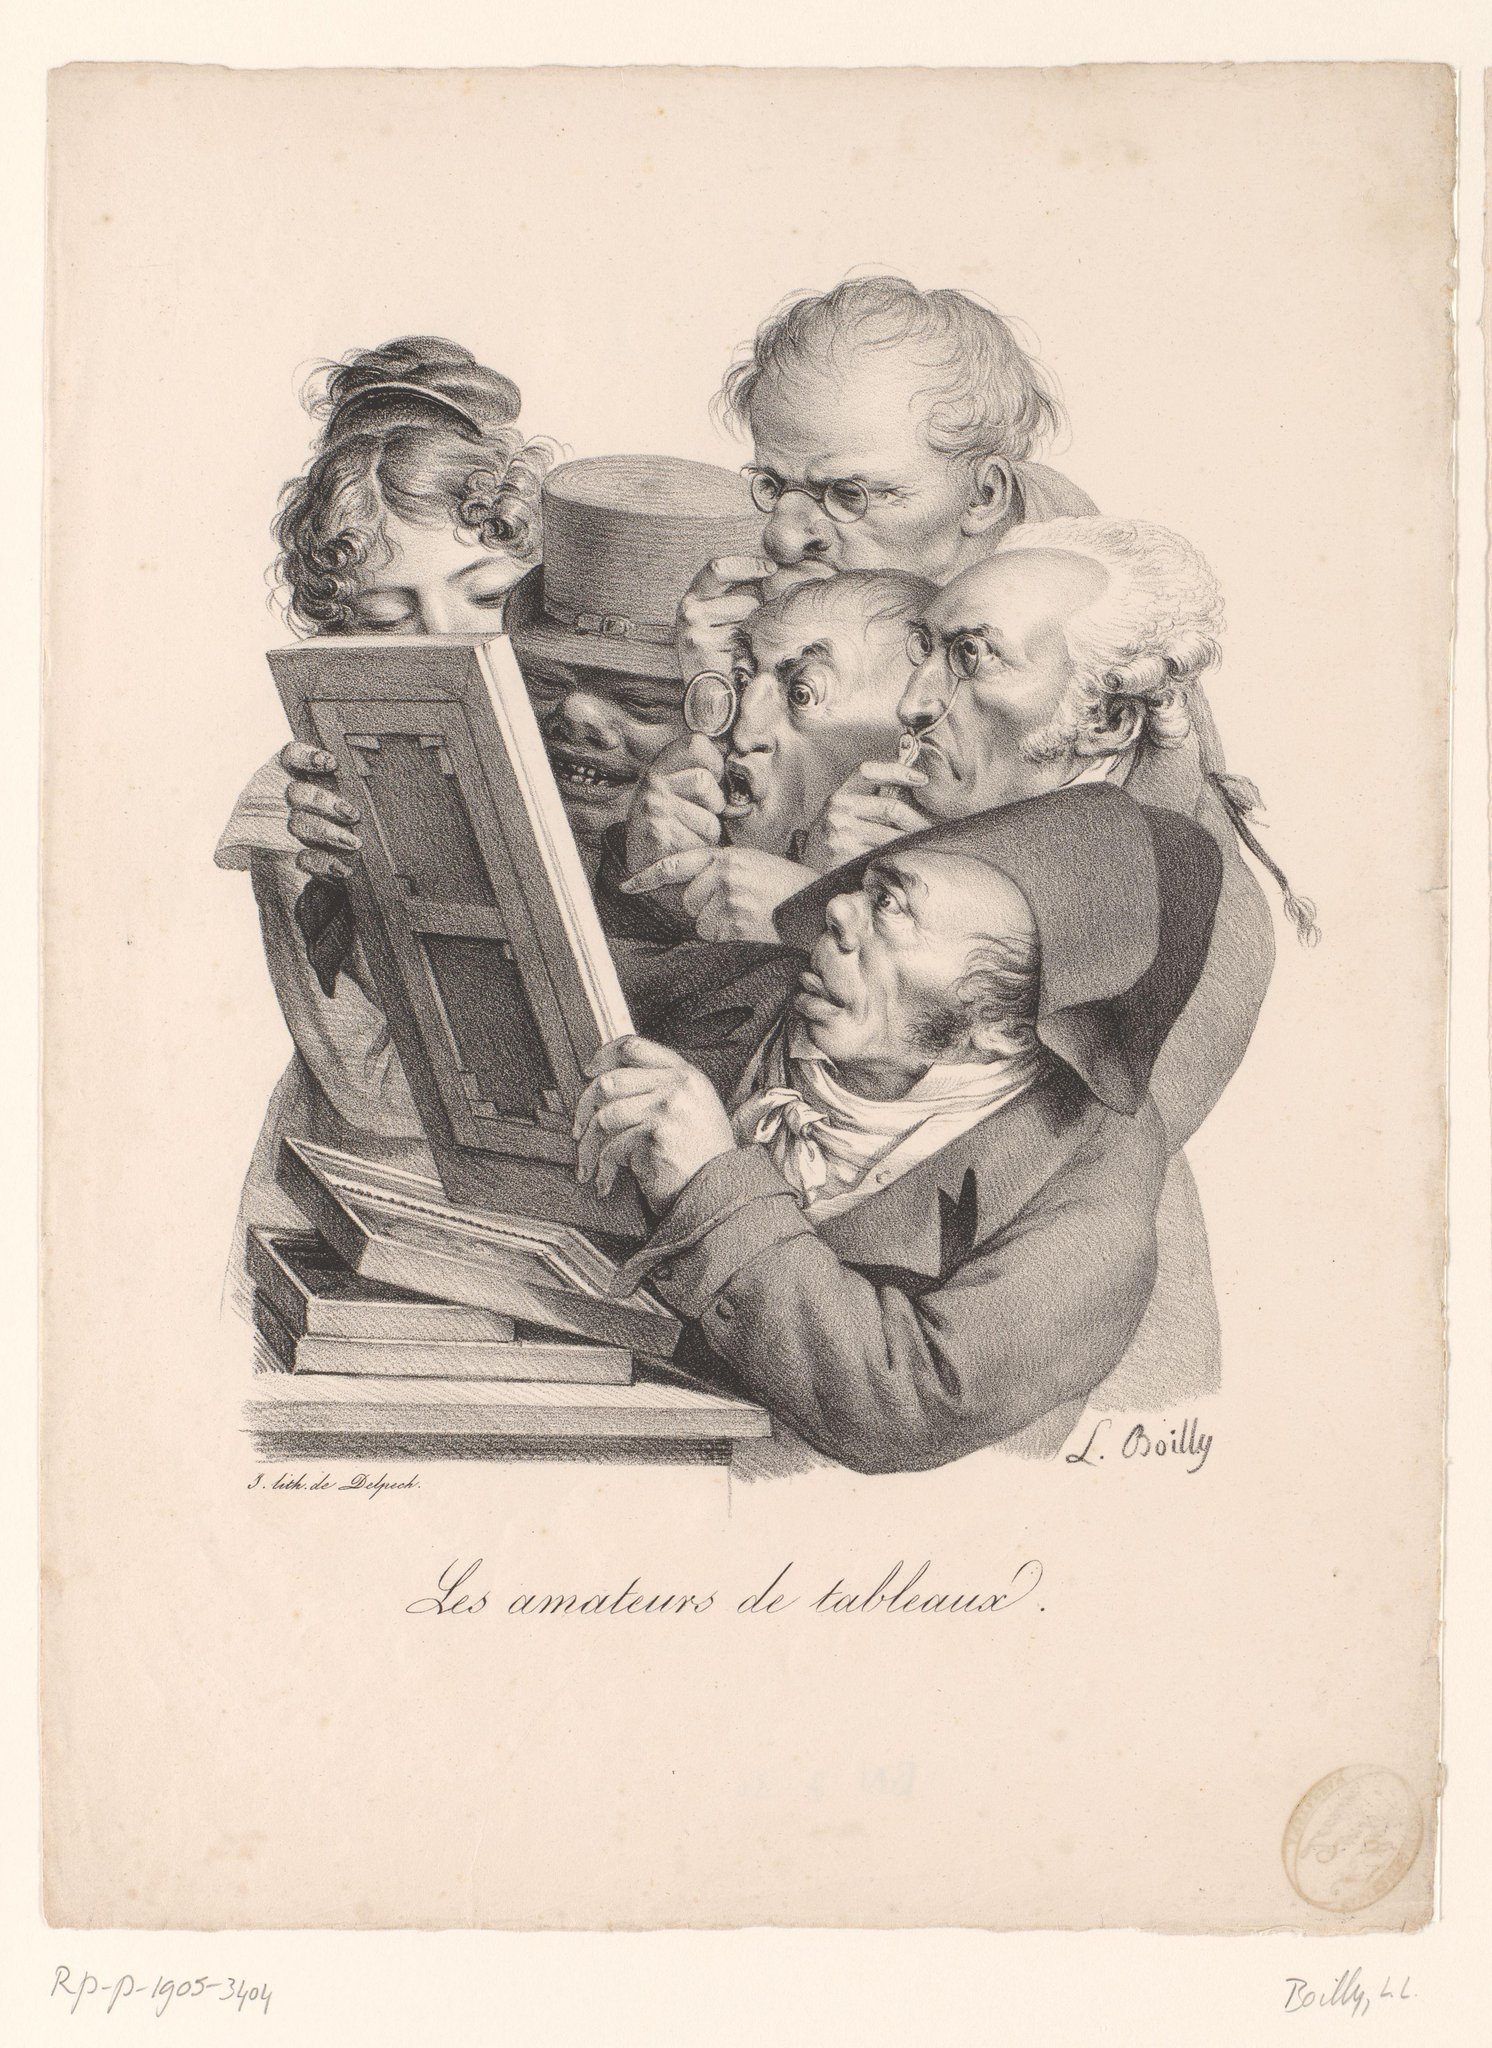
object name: cartoon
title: Karikatuur van zes liefhebbers van schilderijen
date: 1823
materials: paper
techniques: lithograph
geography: paris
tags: caricatures (human types), picture, painting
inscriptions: collector's mark: Lugt 2228a, stamp: ‘F. Buffa en Zoonen, Amsterdam, Kalverstraat no. 221’